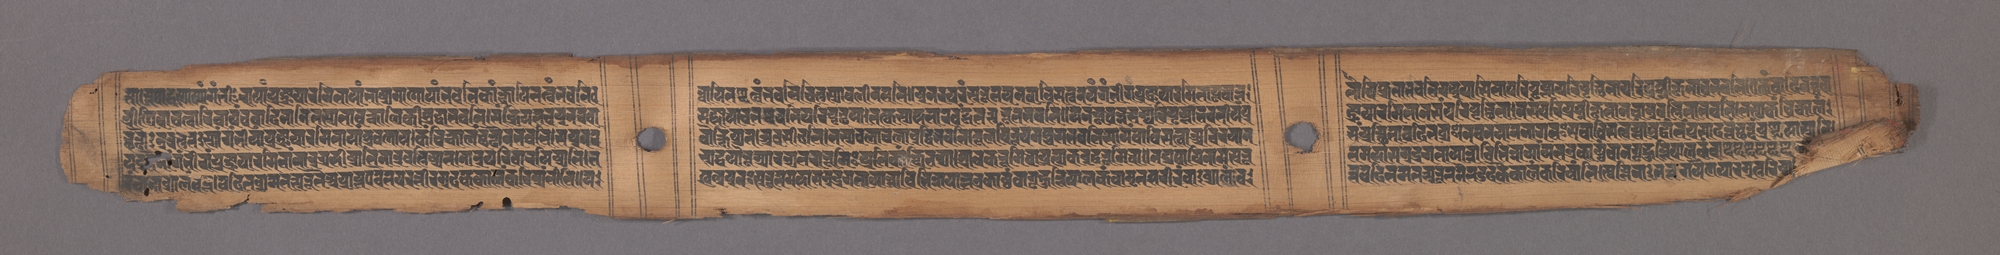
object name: folio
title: Folio from a Manuscript of the Ashtasahasrika Prajnaparamita (Perfection of Wisdom)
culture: indian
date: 1101-1200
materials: ink, leaf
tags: buddhism